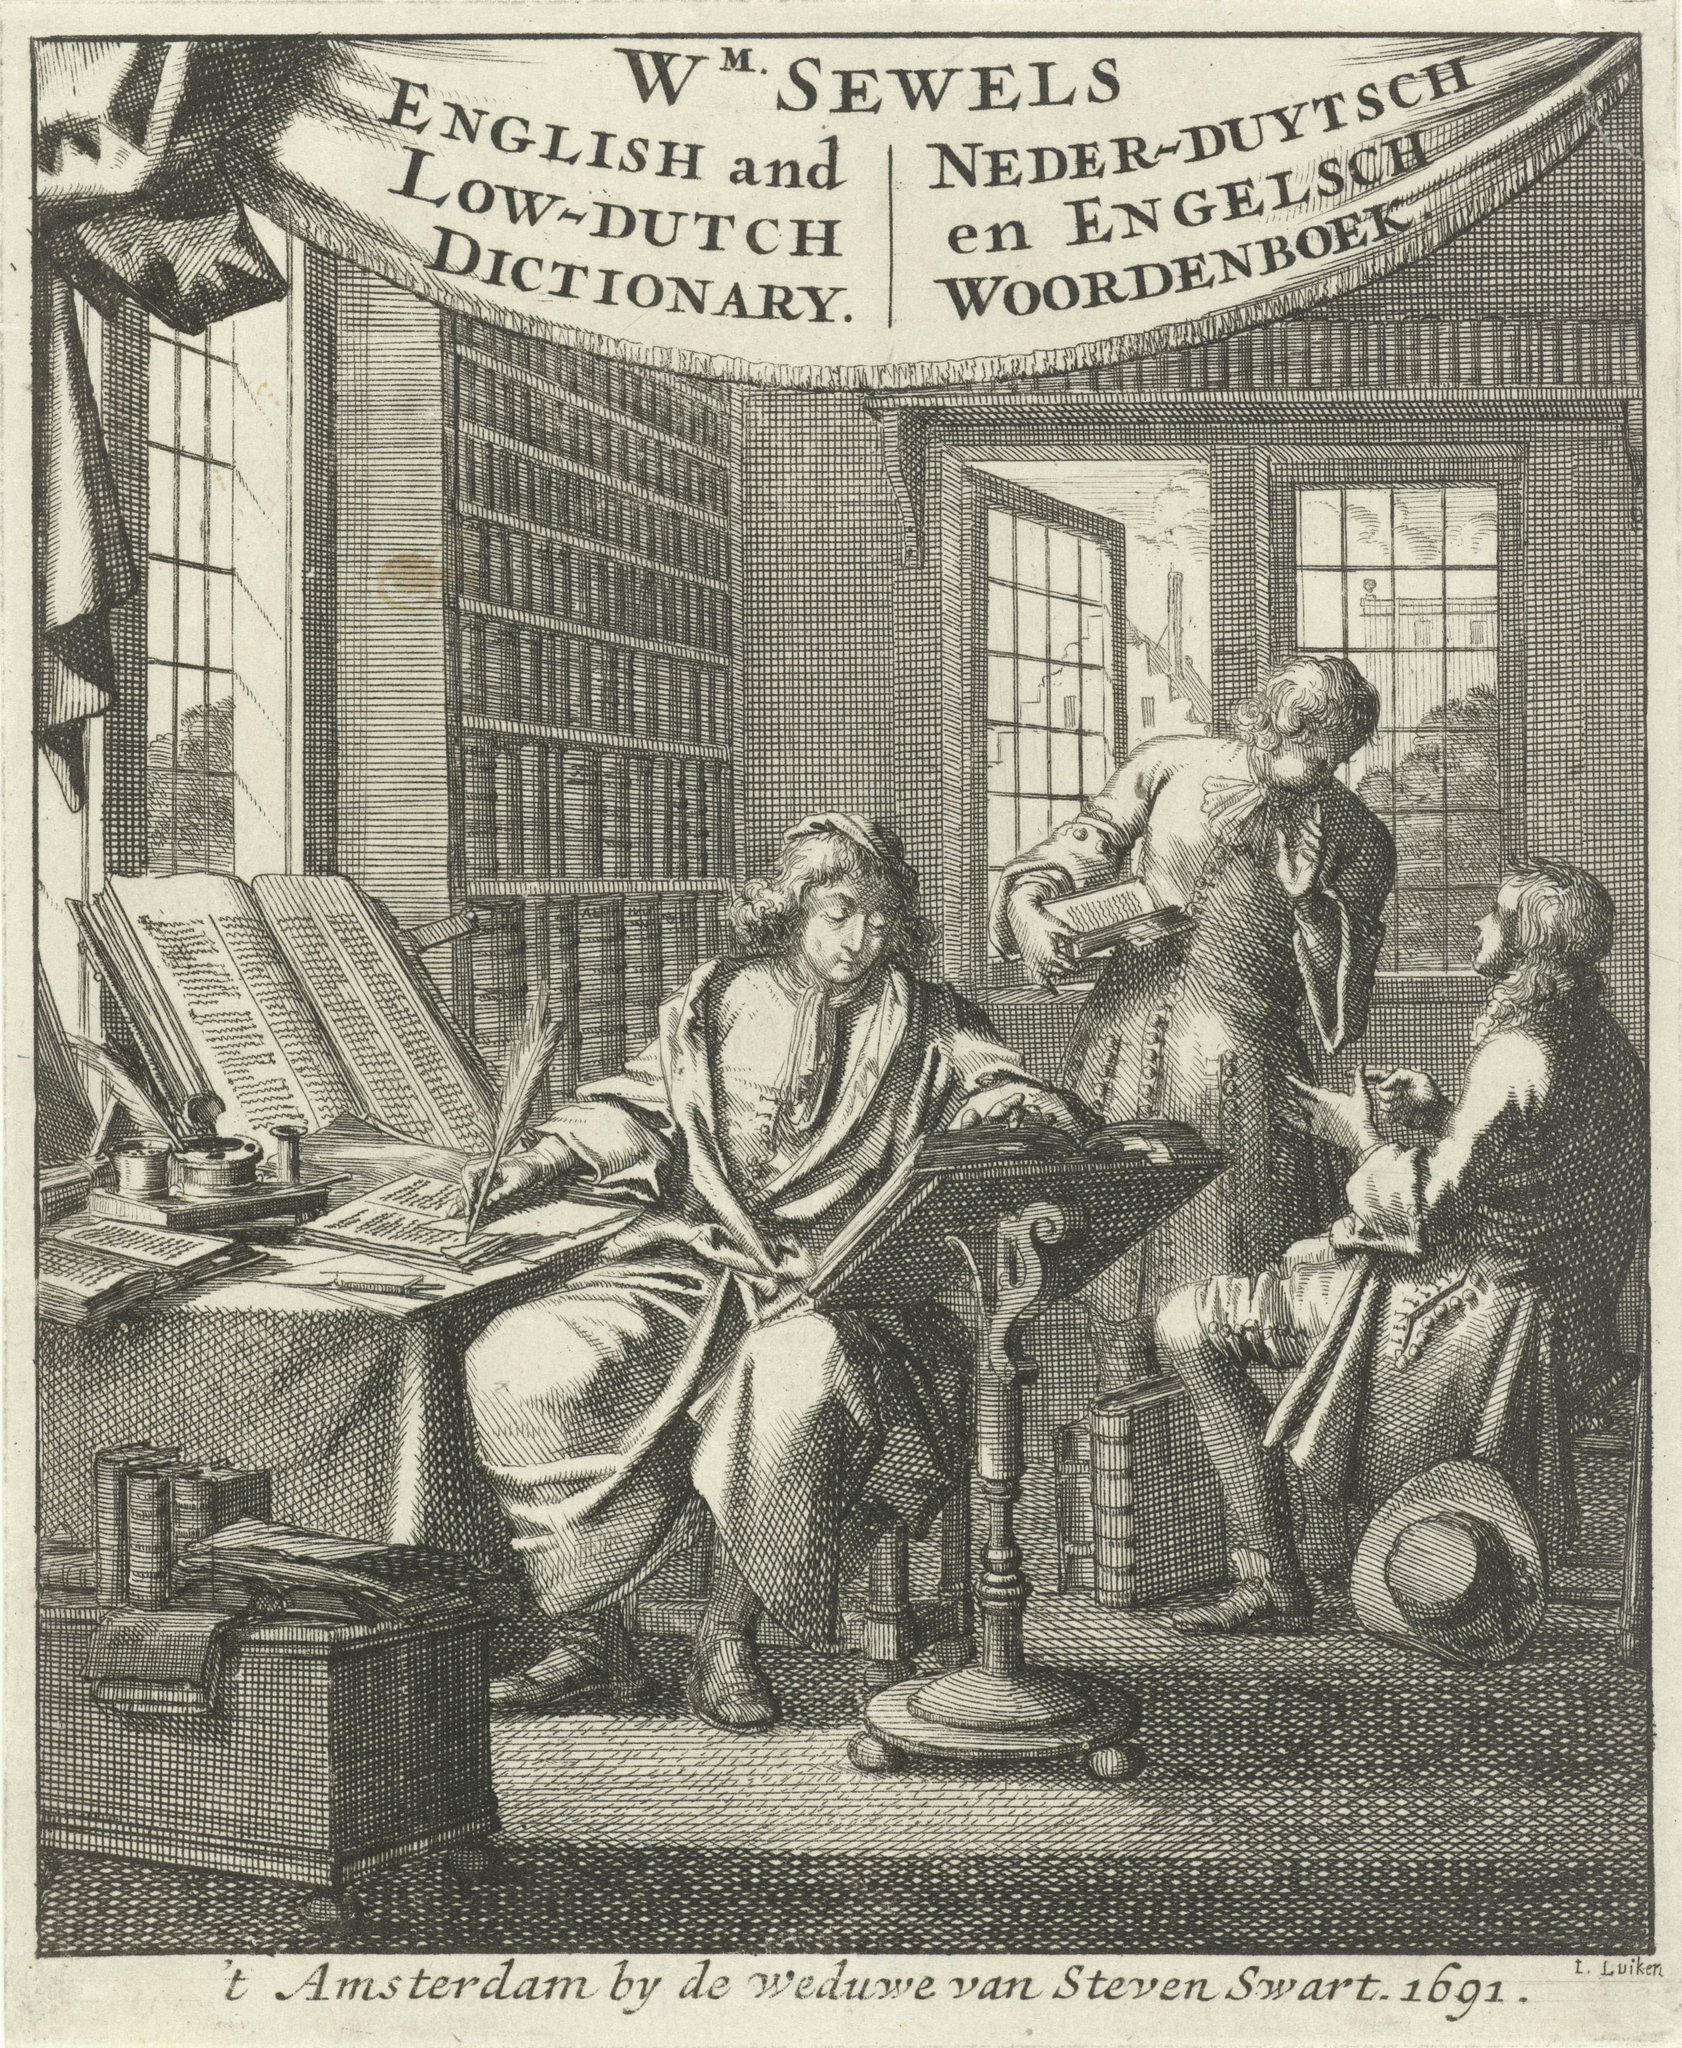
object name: titelblad, titelpagina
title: Titelpagina voor: W. Séwel, A new dictionary English and Dutch (...). Nieuw woordenboek der Engelsche en Nederduytsche taale, 1691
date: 1691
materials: paper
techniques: etching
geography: amsterdam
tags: group of scholars or philosophers, study; 'studiolo'; library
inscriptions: collector's mark: Lugt 2228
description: Titelpagina voor: Séwel, Willem. A new dictionary English and Dutch (...). Nieuw woordenboek der Engelsche en Nederduytsche taale. Amsterdam: weduwe Steven Swart, 1691.